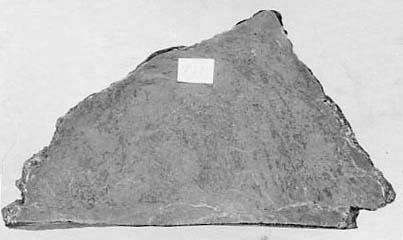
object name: fragment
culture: russian, siberia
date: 1902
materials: jade